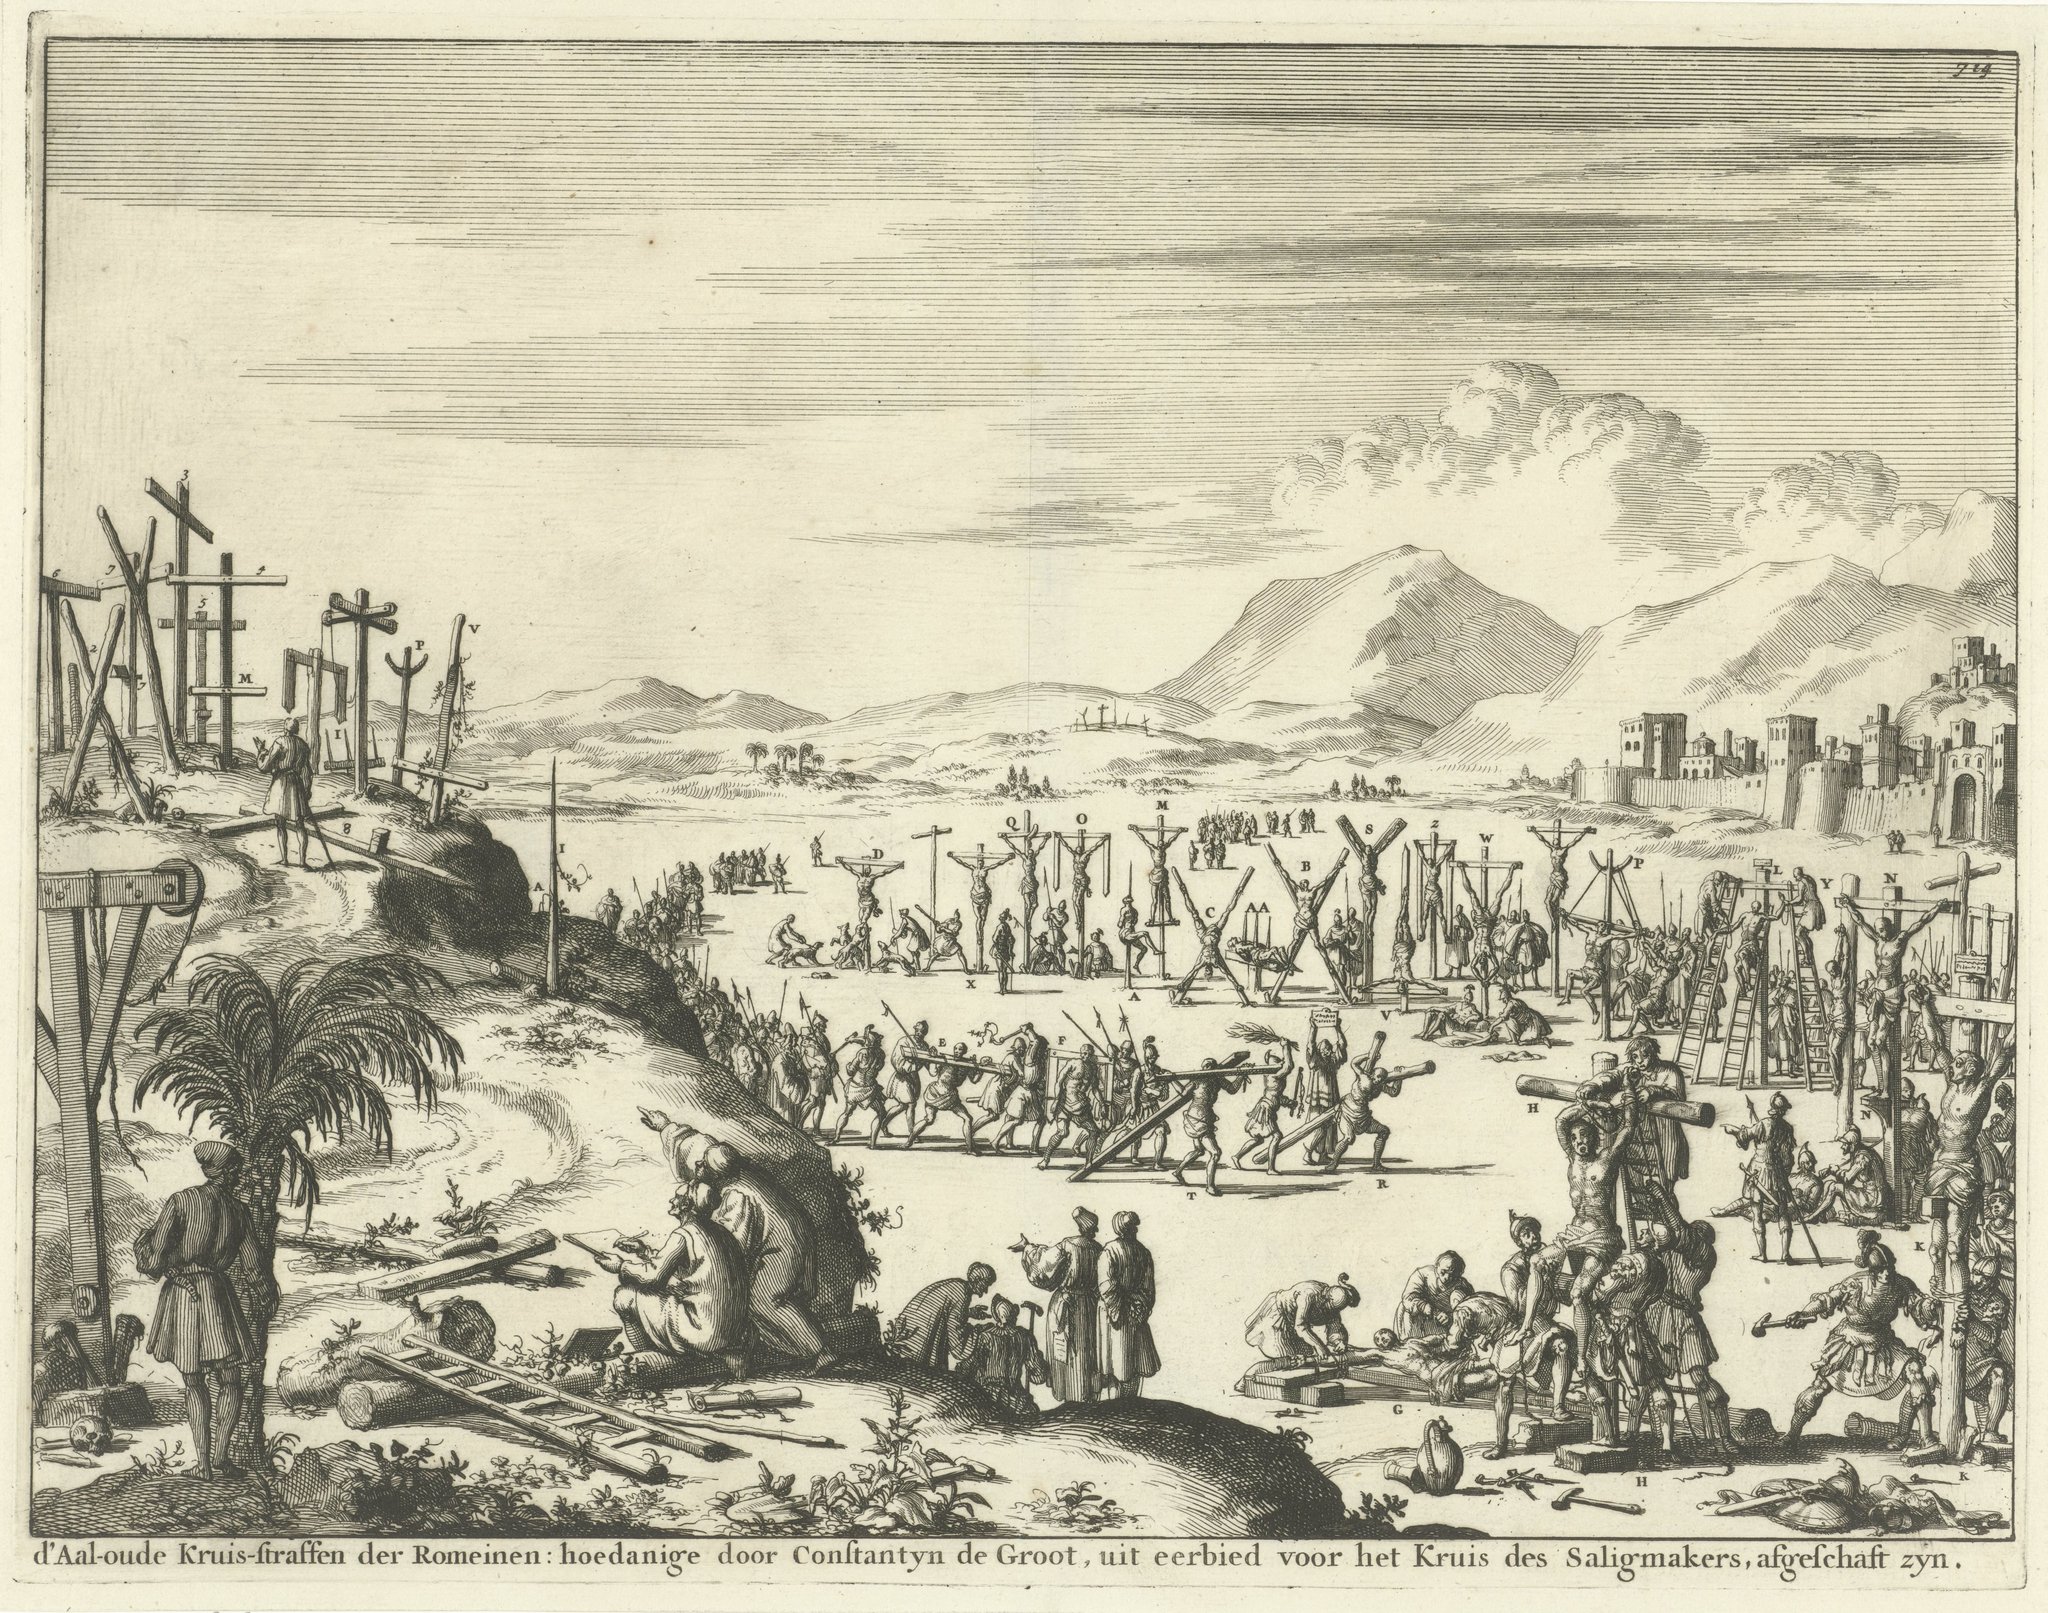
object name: print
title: d'Aal-oude Kruis-straffen der Romeinen: hoedanige door Constantyn de Groot, uit eerbied voor het Kruis des Saligmakers, afgeschaft zyn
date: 1690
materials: paper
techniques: etching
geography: amsterdam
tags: violent death by crucifixion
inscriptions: collector's mark: Lugt 2228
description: Illustratie opgenomen in: Goeree, Wilhelmus. Voor-bereidselen tot de bybelsche wysheid, en gebruik der heilige en kerklijke historien, 3 delen. Amsterdam: Wilhelmus Goeree I, 1690, dl. I.